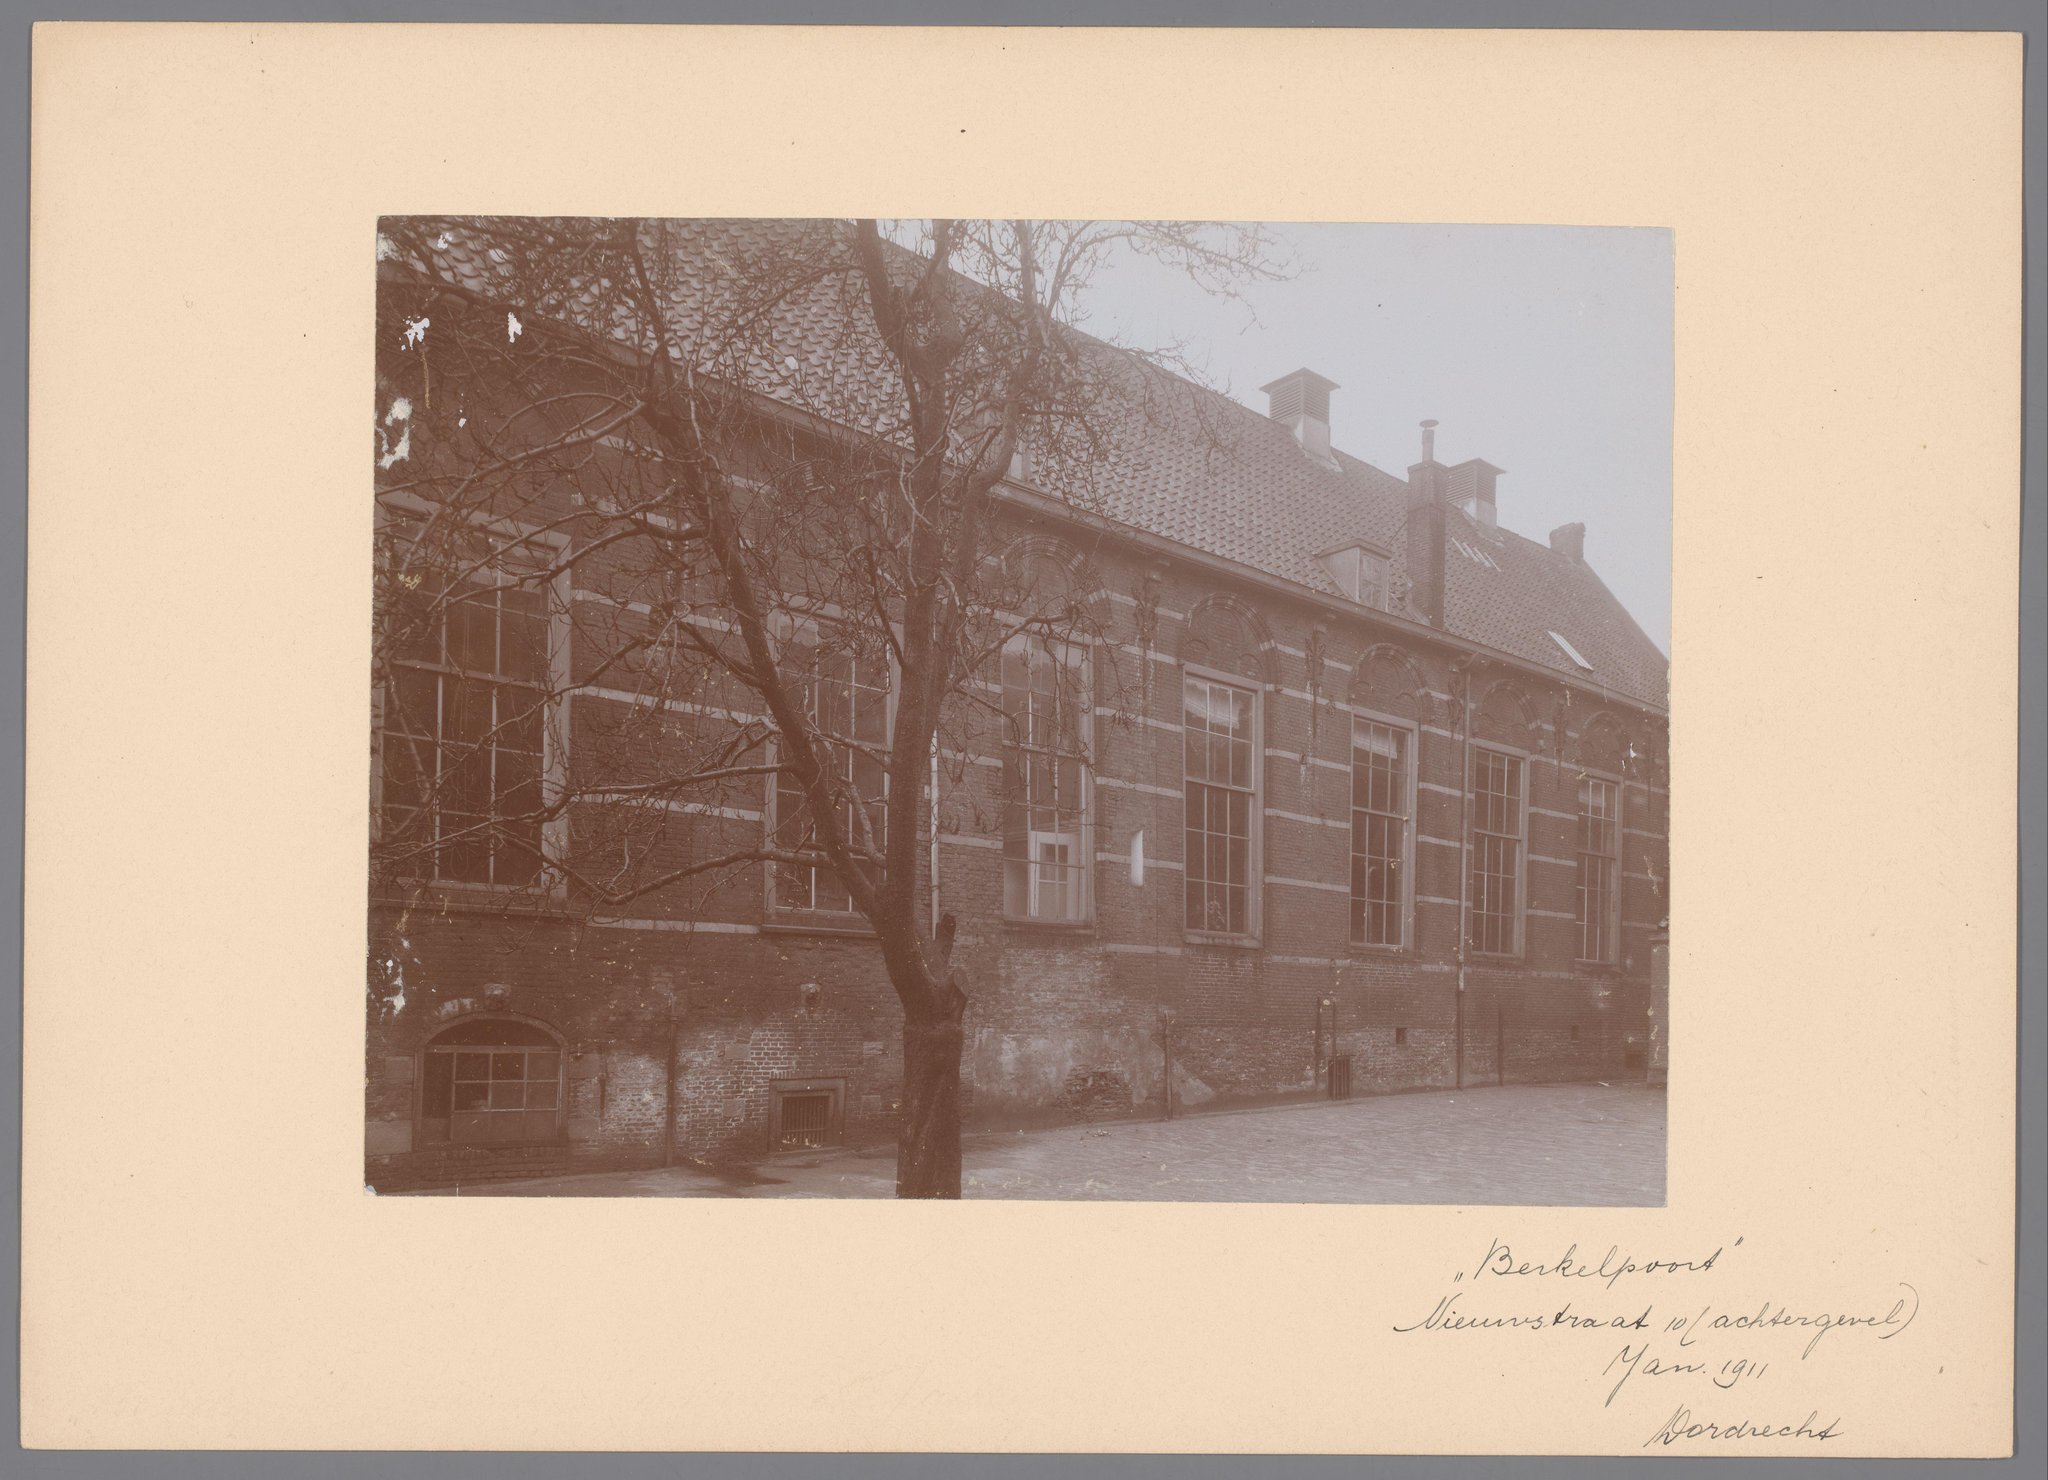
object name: photograph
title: Achtergevel van Nieuwstraat 10 te Dordrecht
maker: anoniem (monumentenzorg)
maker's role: fotograaf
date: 1911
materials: cardboard, photographic support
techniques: collodion silver print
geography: hofstraat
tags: urban housing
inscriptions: annotation: ‘"Berkelpoort"/ Nieuwstraat 10 (achtergevel)/ Jan. 1911/ Dordrecht’